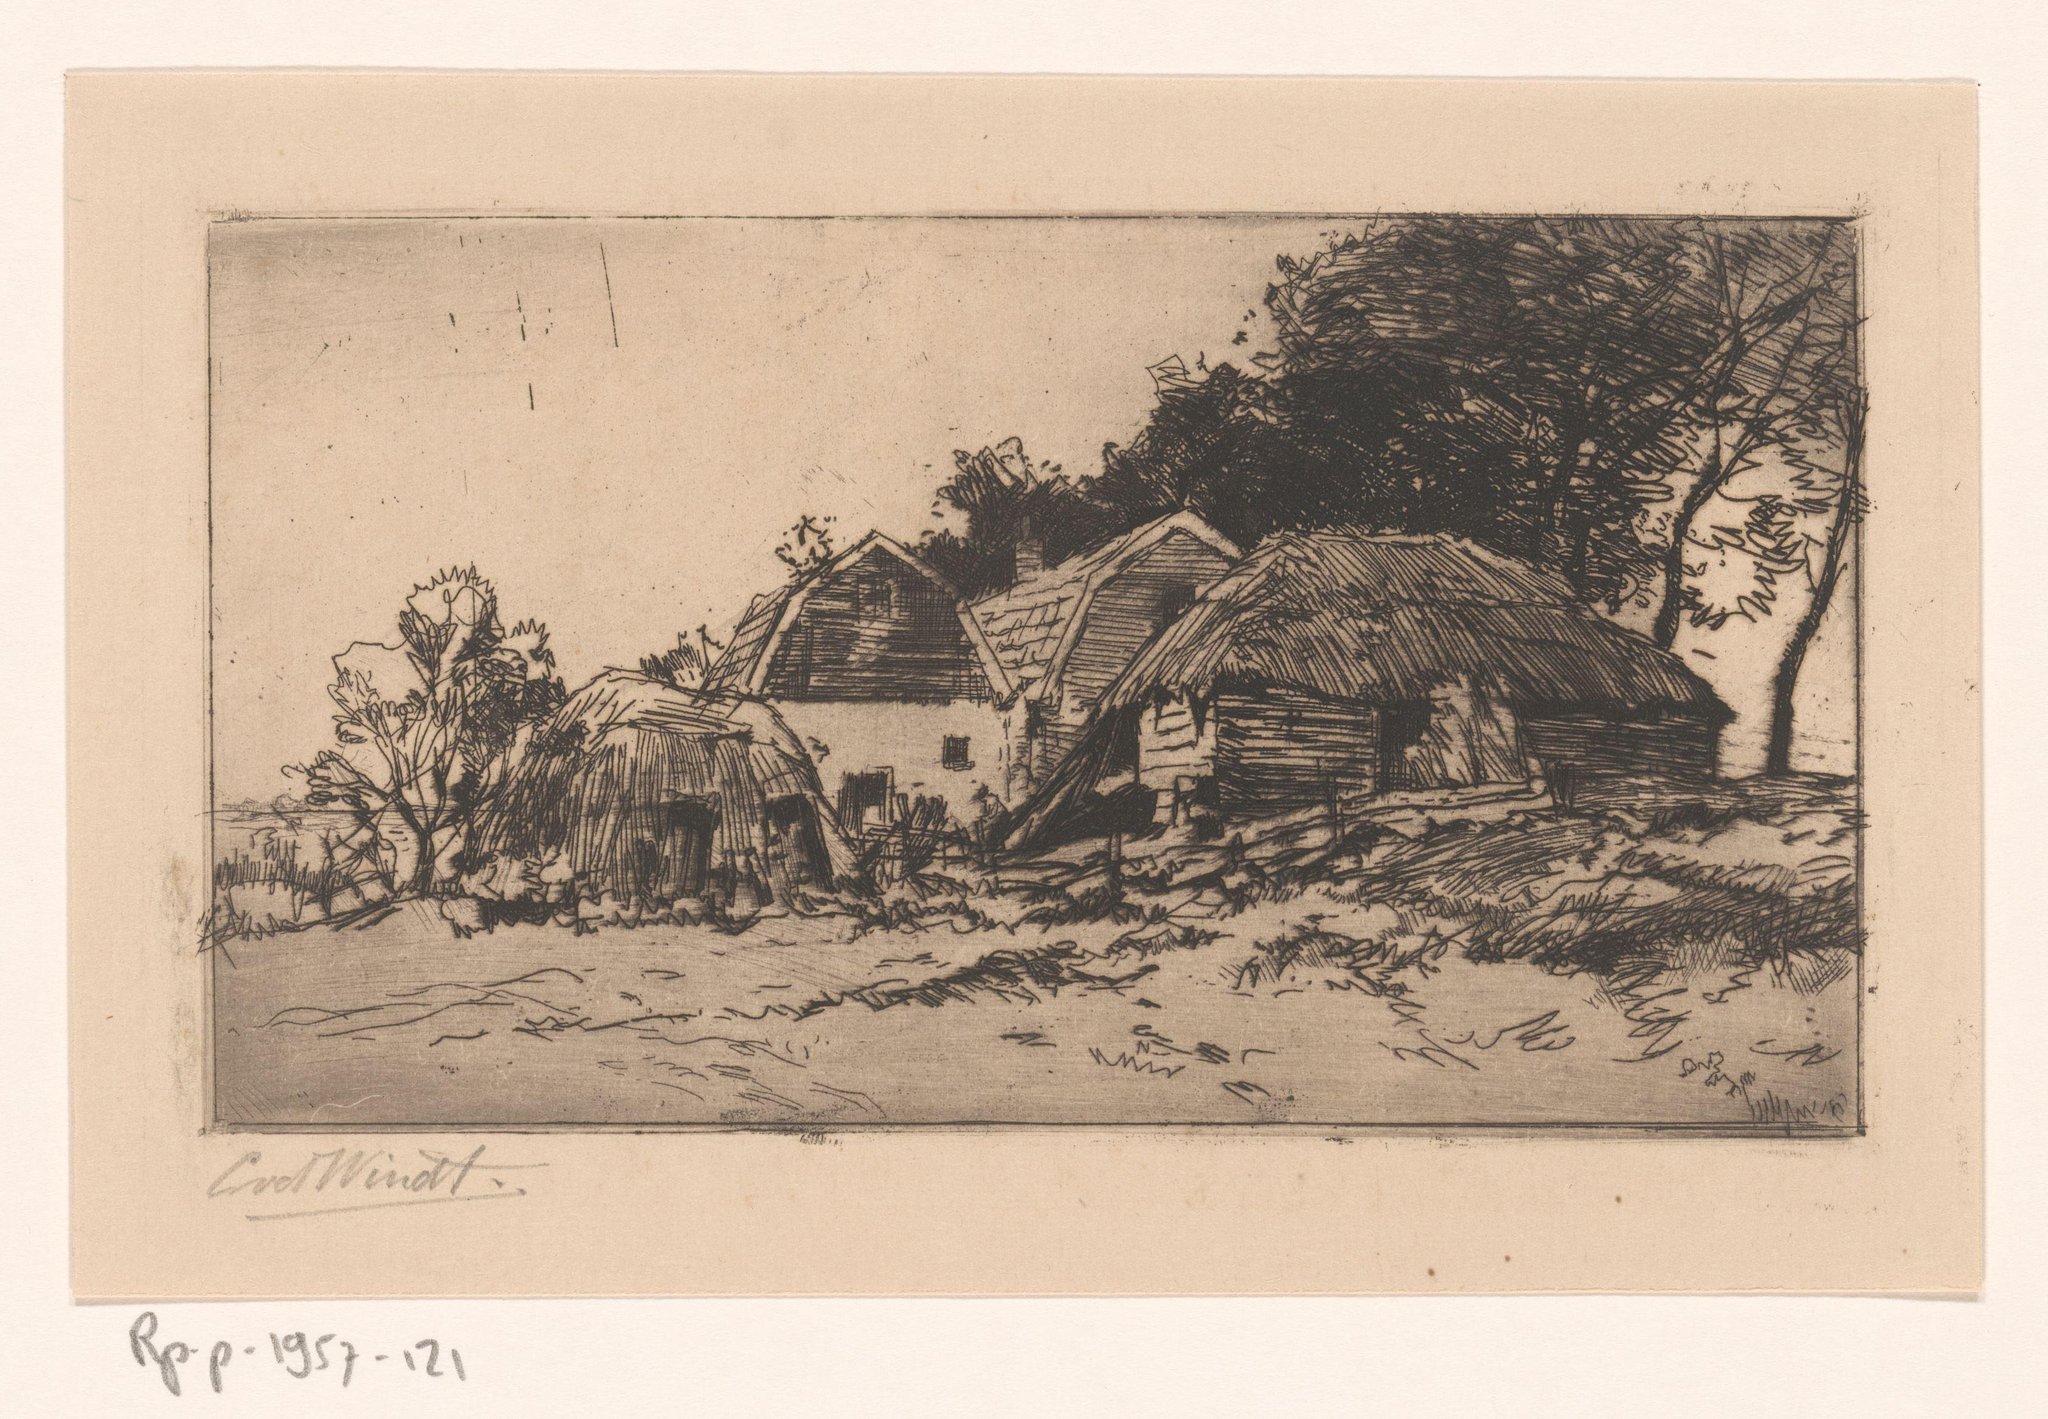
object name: print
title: Twee huizen en een schuur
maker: chris van der windt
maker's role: print maker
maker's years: 1877-1952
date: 1887-1952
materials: paper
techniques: drypoint, etching, intaglio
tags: farm (building)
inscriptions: collector's mark: Lugt 2228